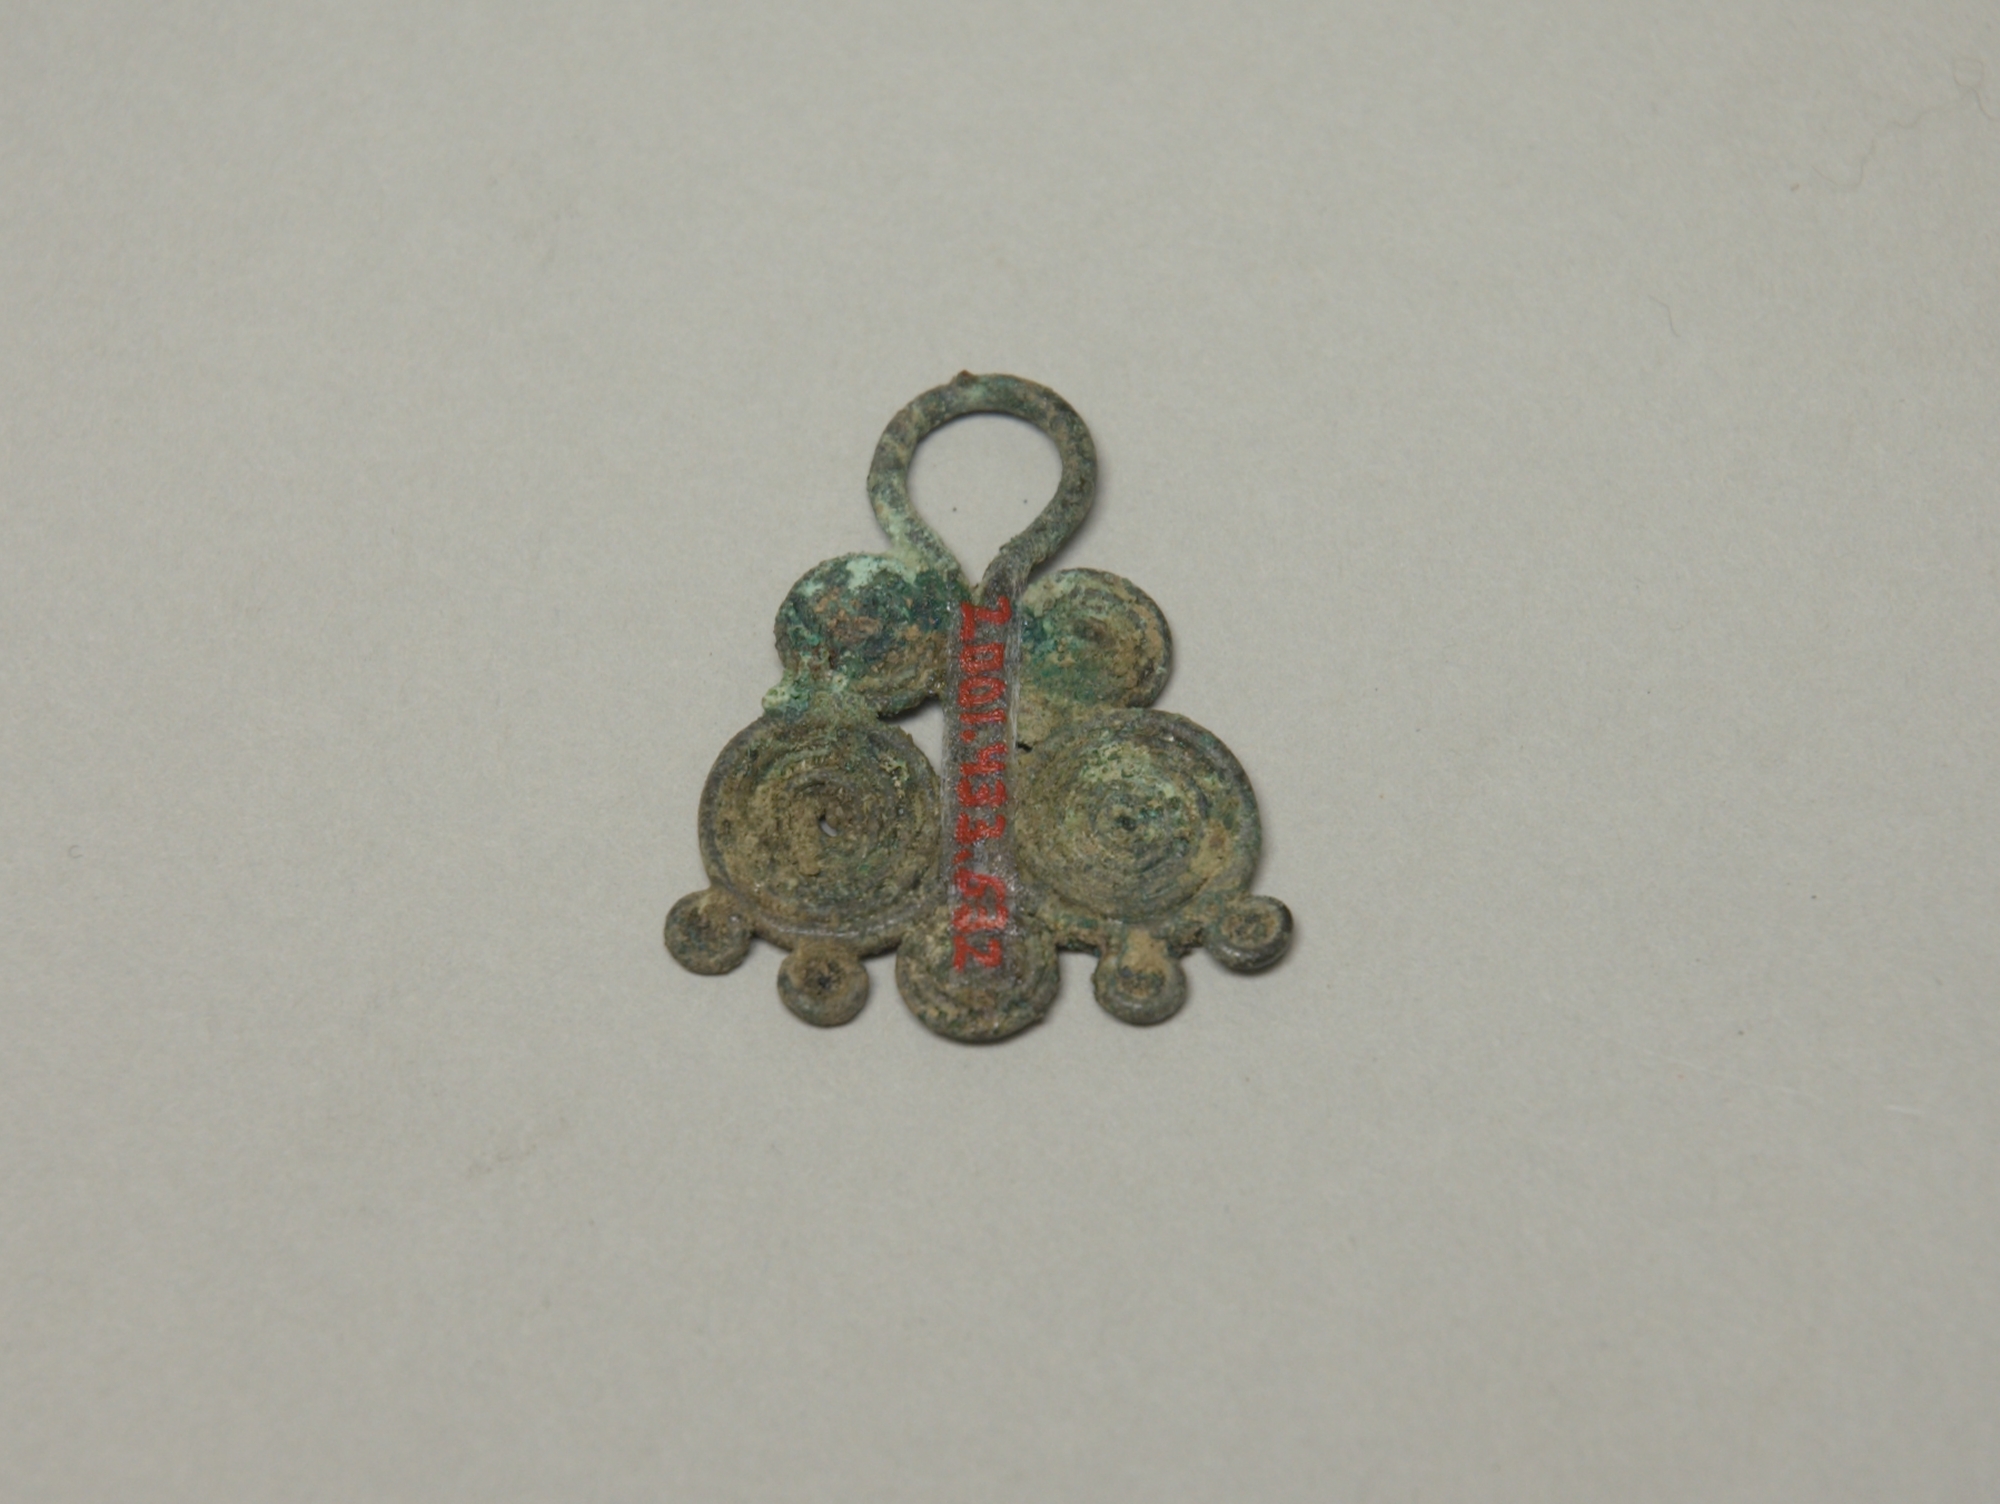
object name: pendant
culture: indonesian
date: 500 BCE-300 CE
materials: bronze